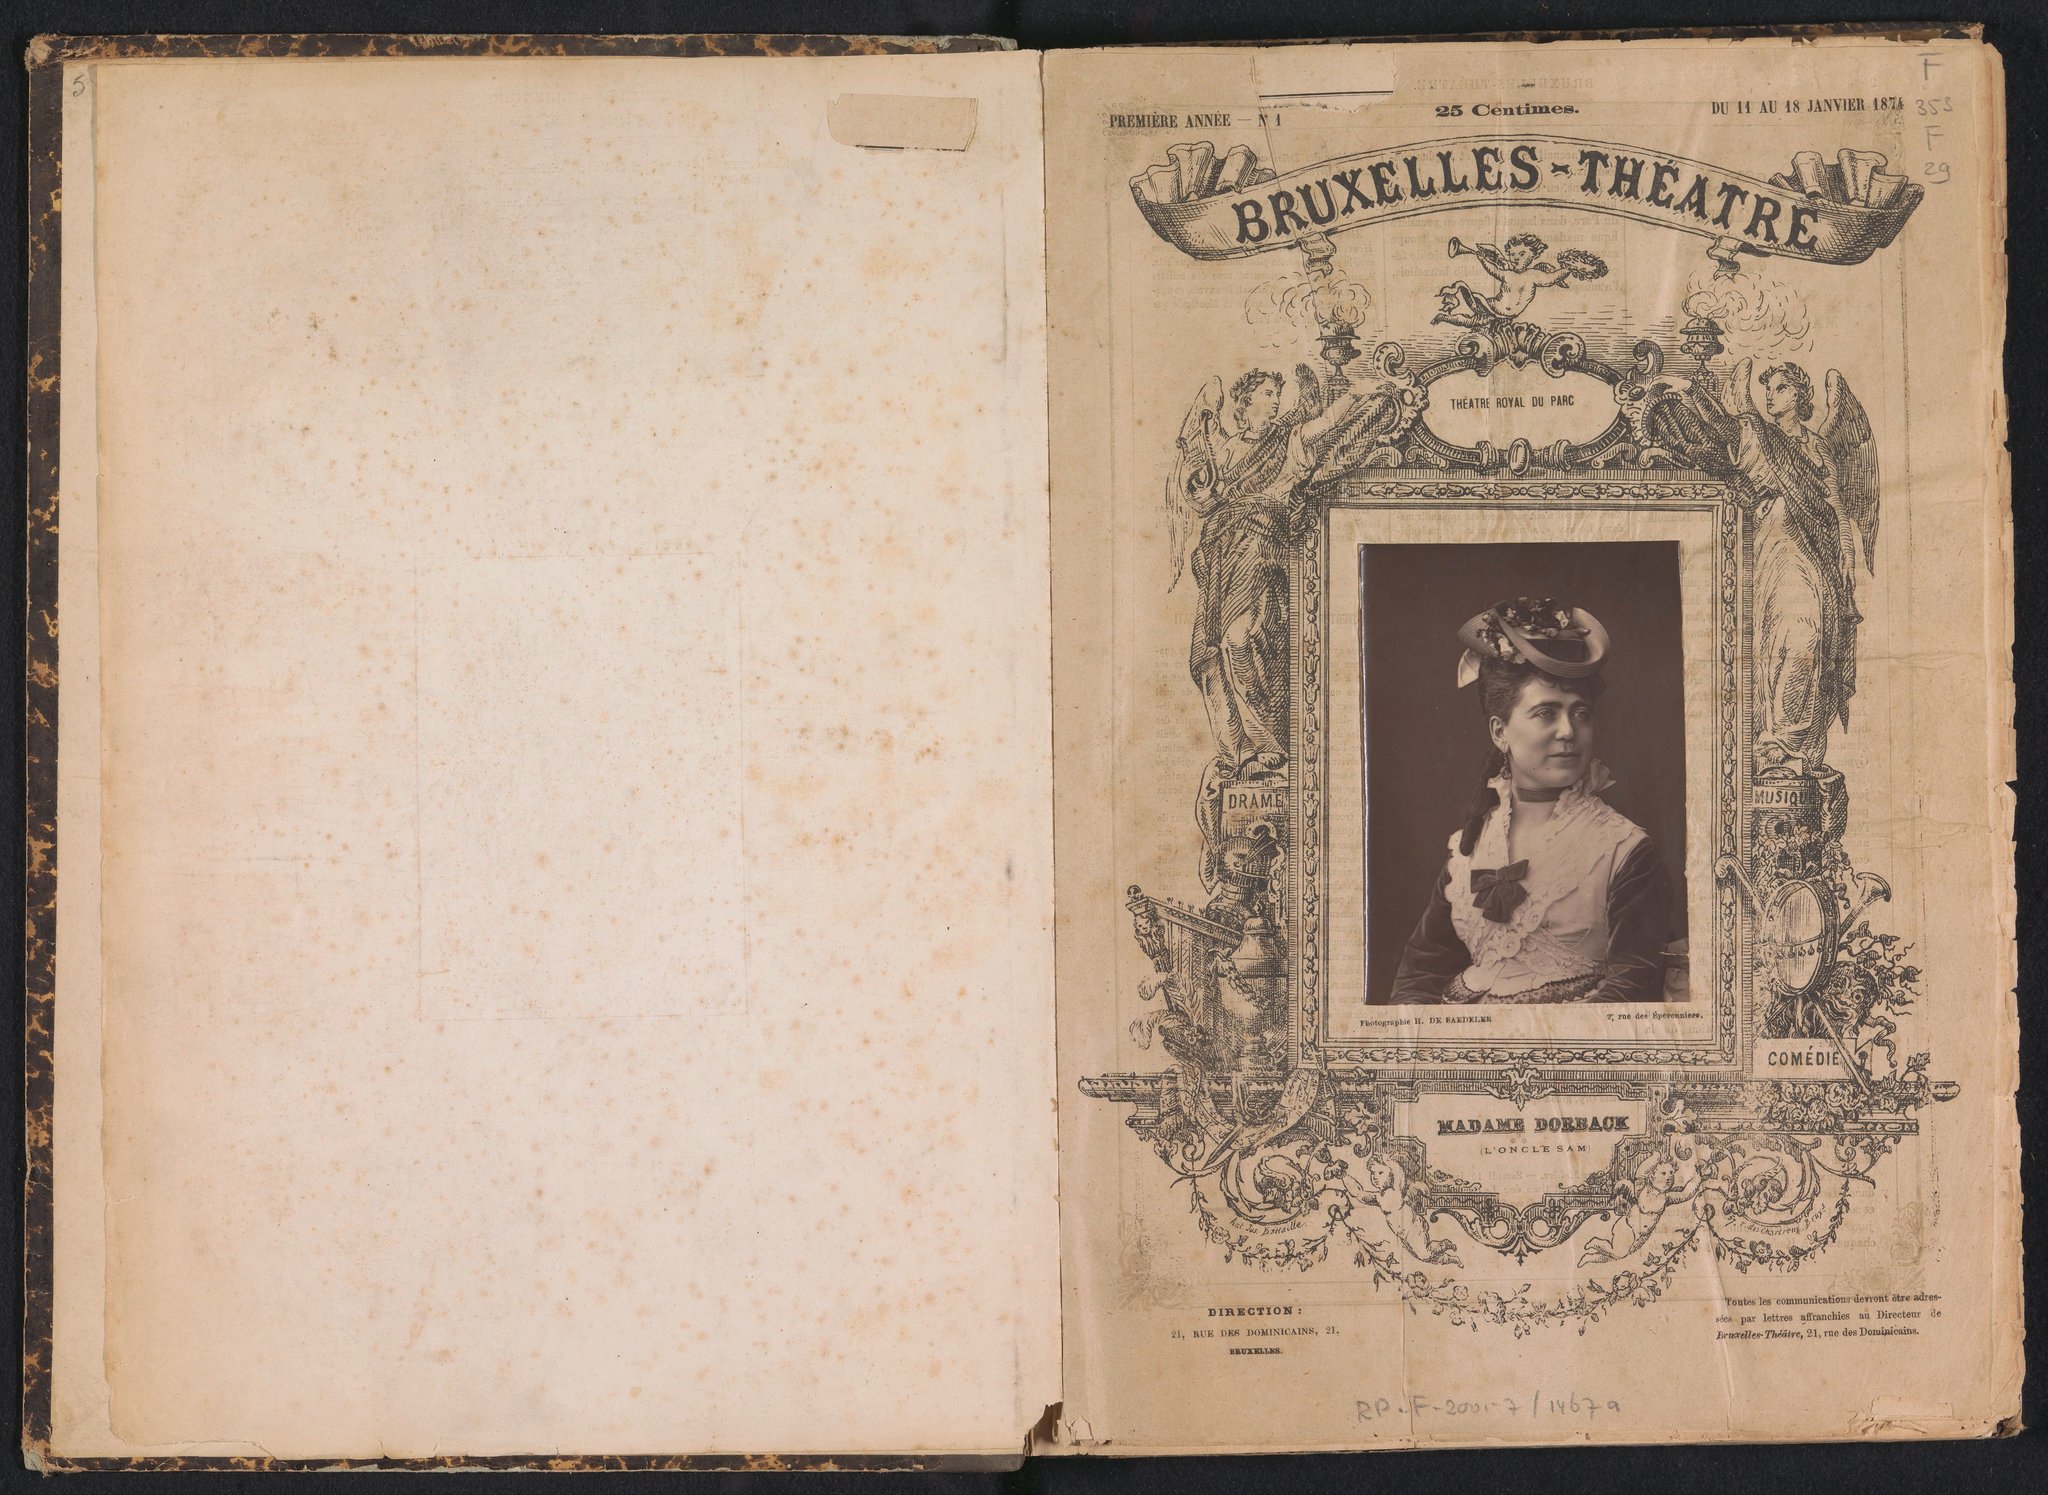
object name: photomechanical print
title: Madame Dorback (l'oncle Sam)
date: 1869-1874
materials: paper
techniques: woodburytype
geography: brussels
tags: portrait of actor, actress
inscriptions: number: ‘N 1’